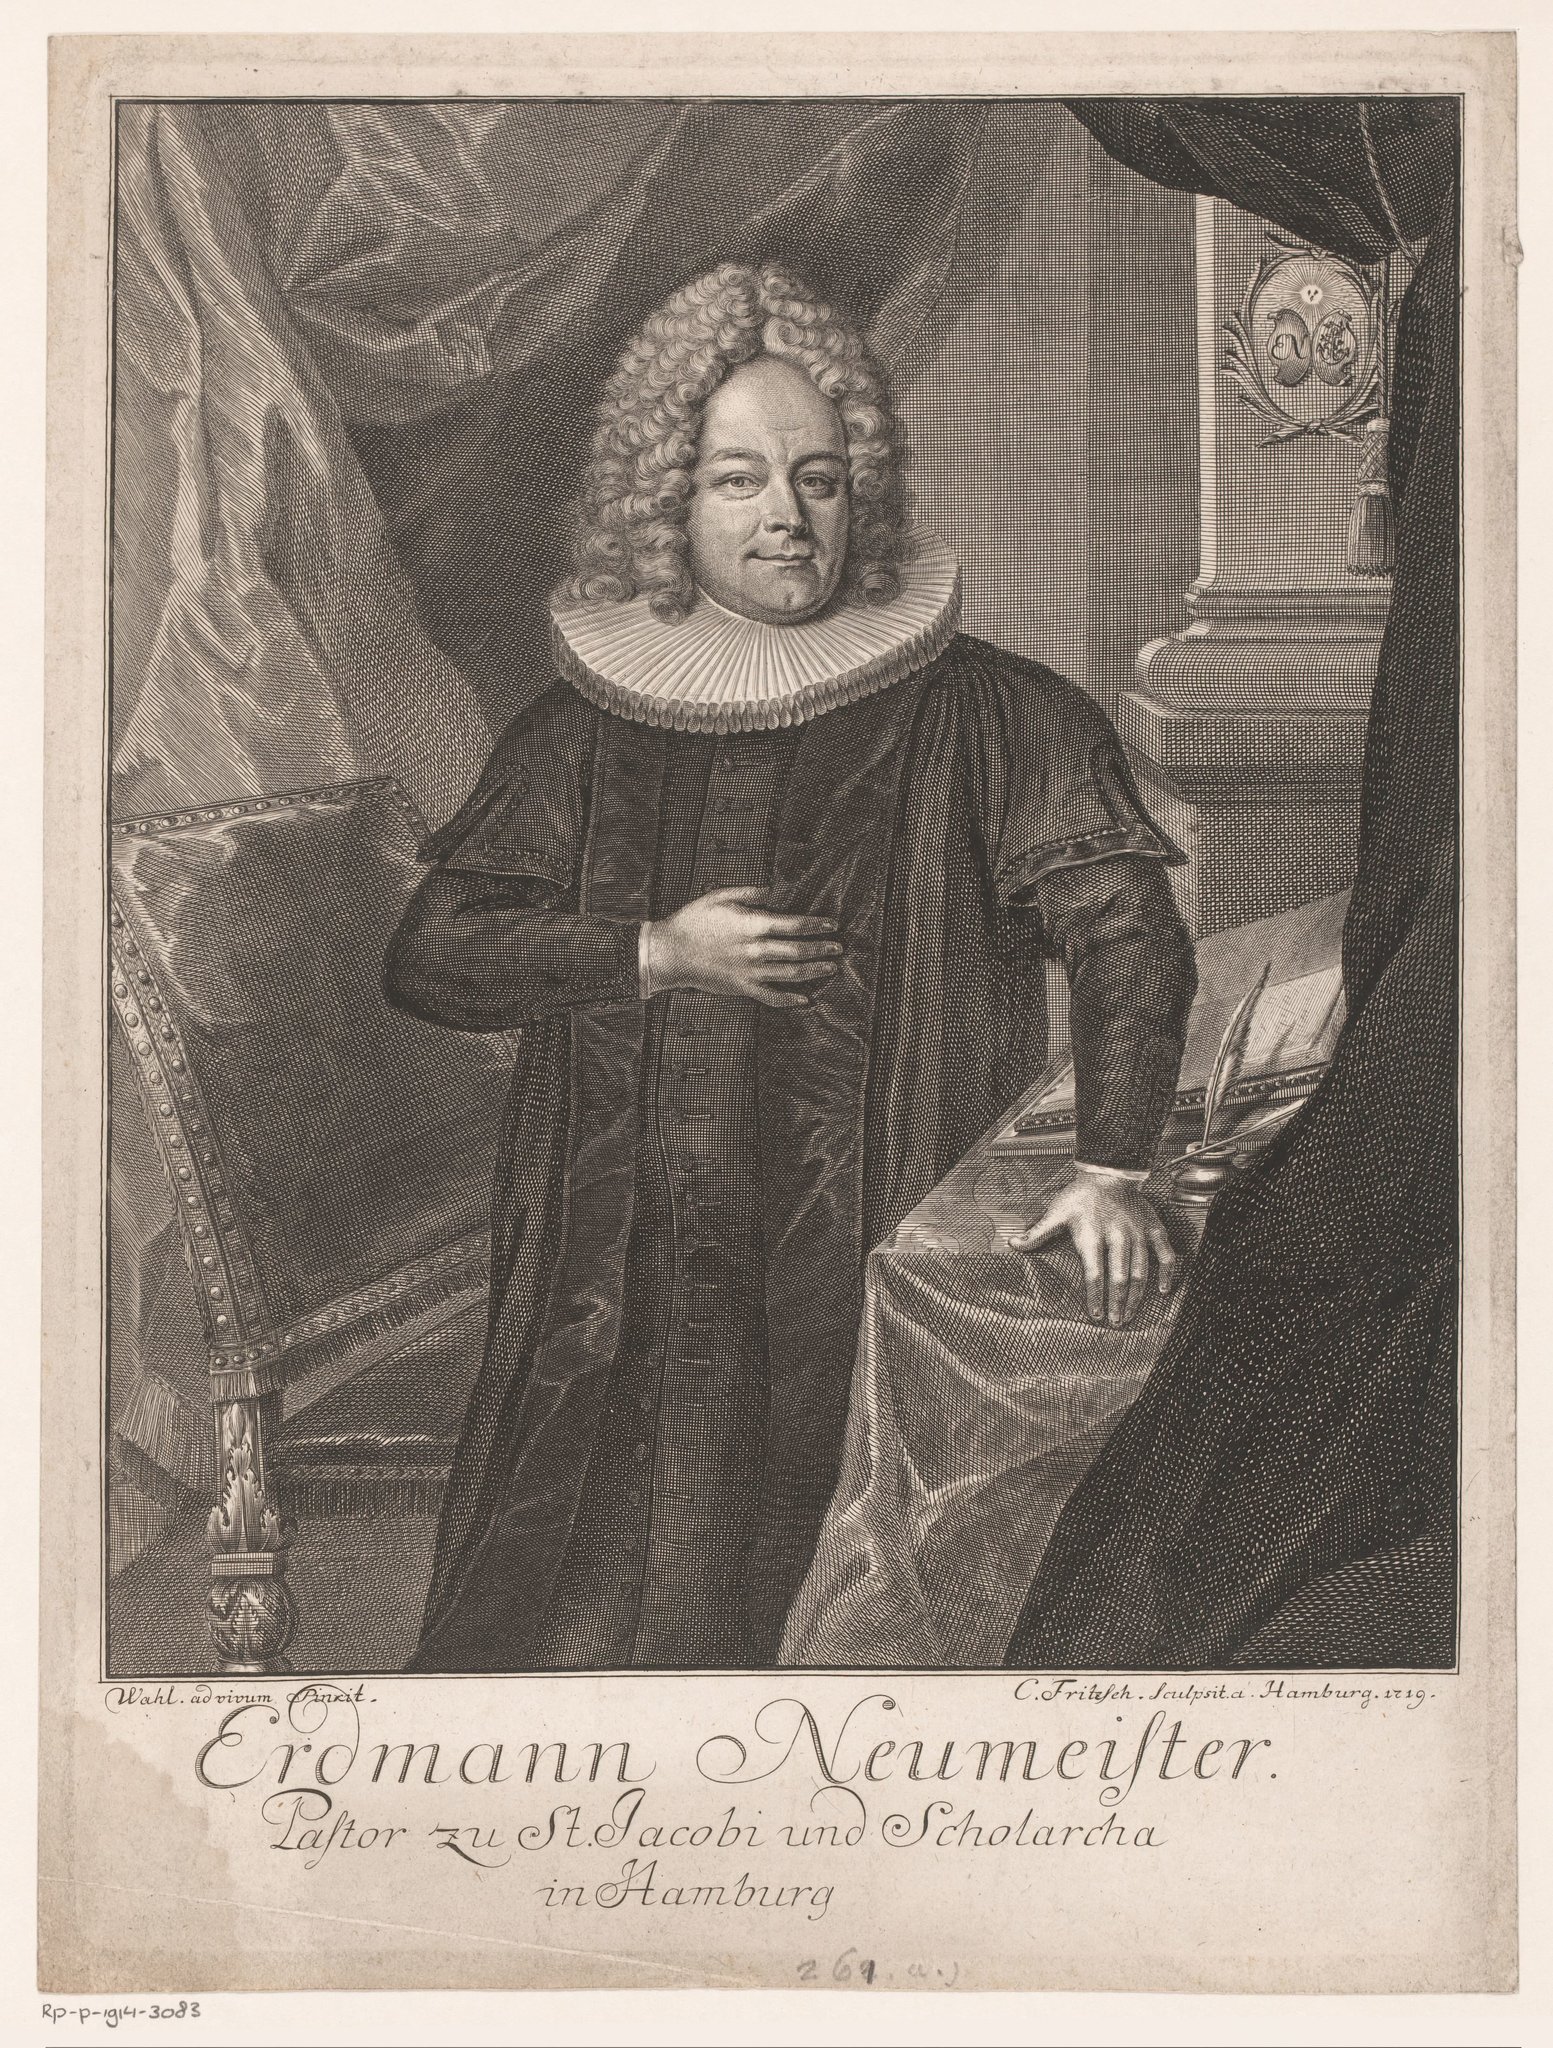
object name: print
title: Portret van Erdmann Neumeister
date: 1719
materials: paper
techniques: engraving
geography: hamburg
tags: erdmann neumeister, writing tools, historical persons, abstract ideas and concepts (+ emblematical representation of concept)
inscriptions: collector's mark: Lugt 2228